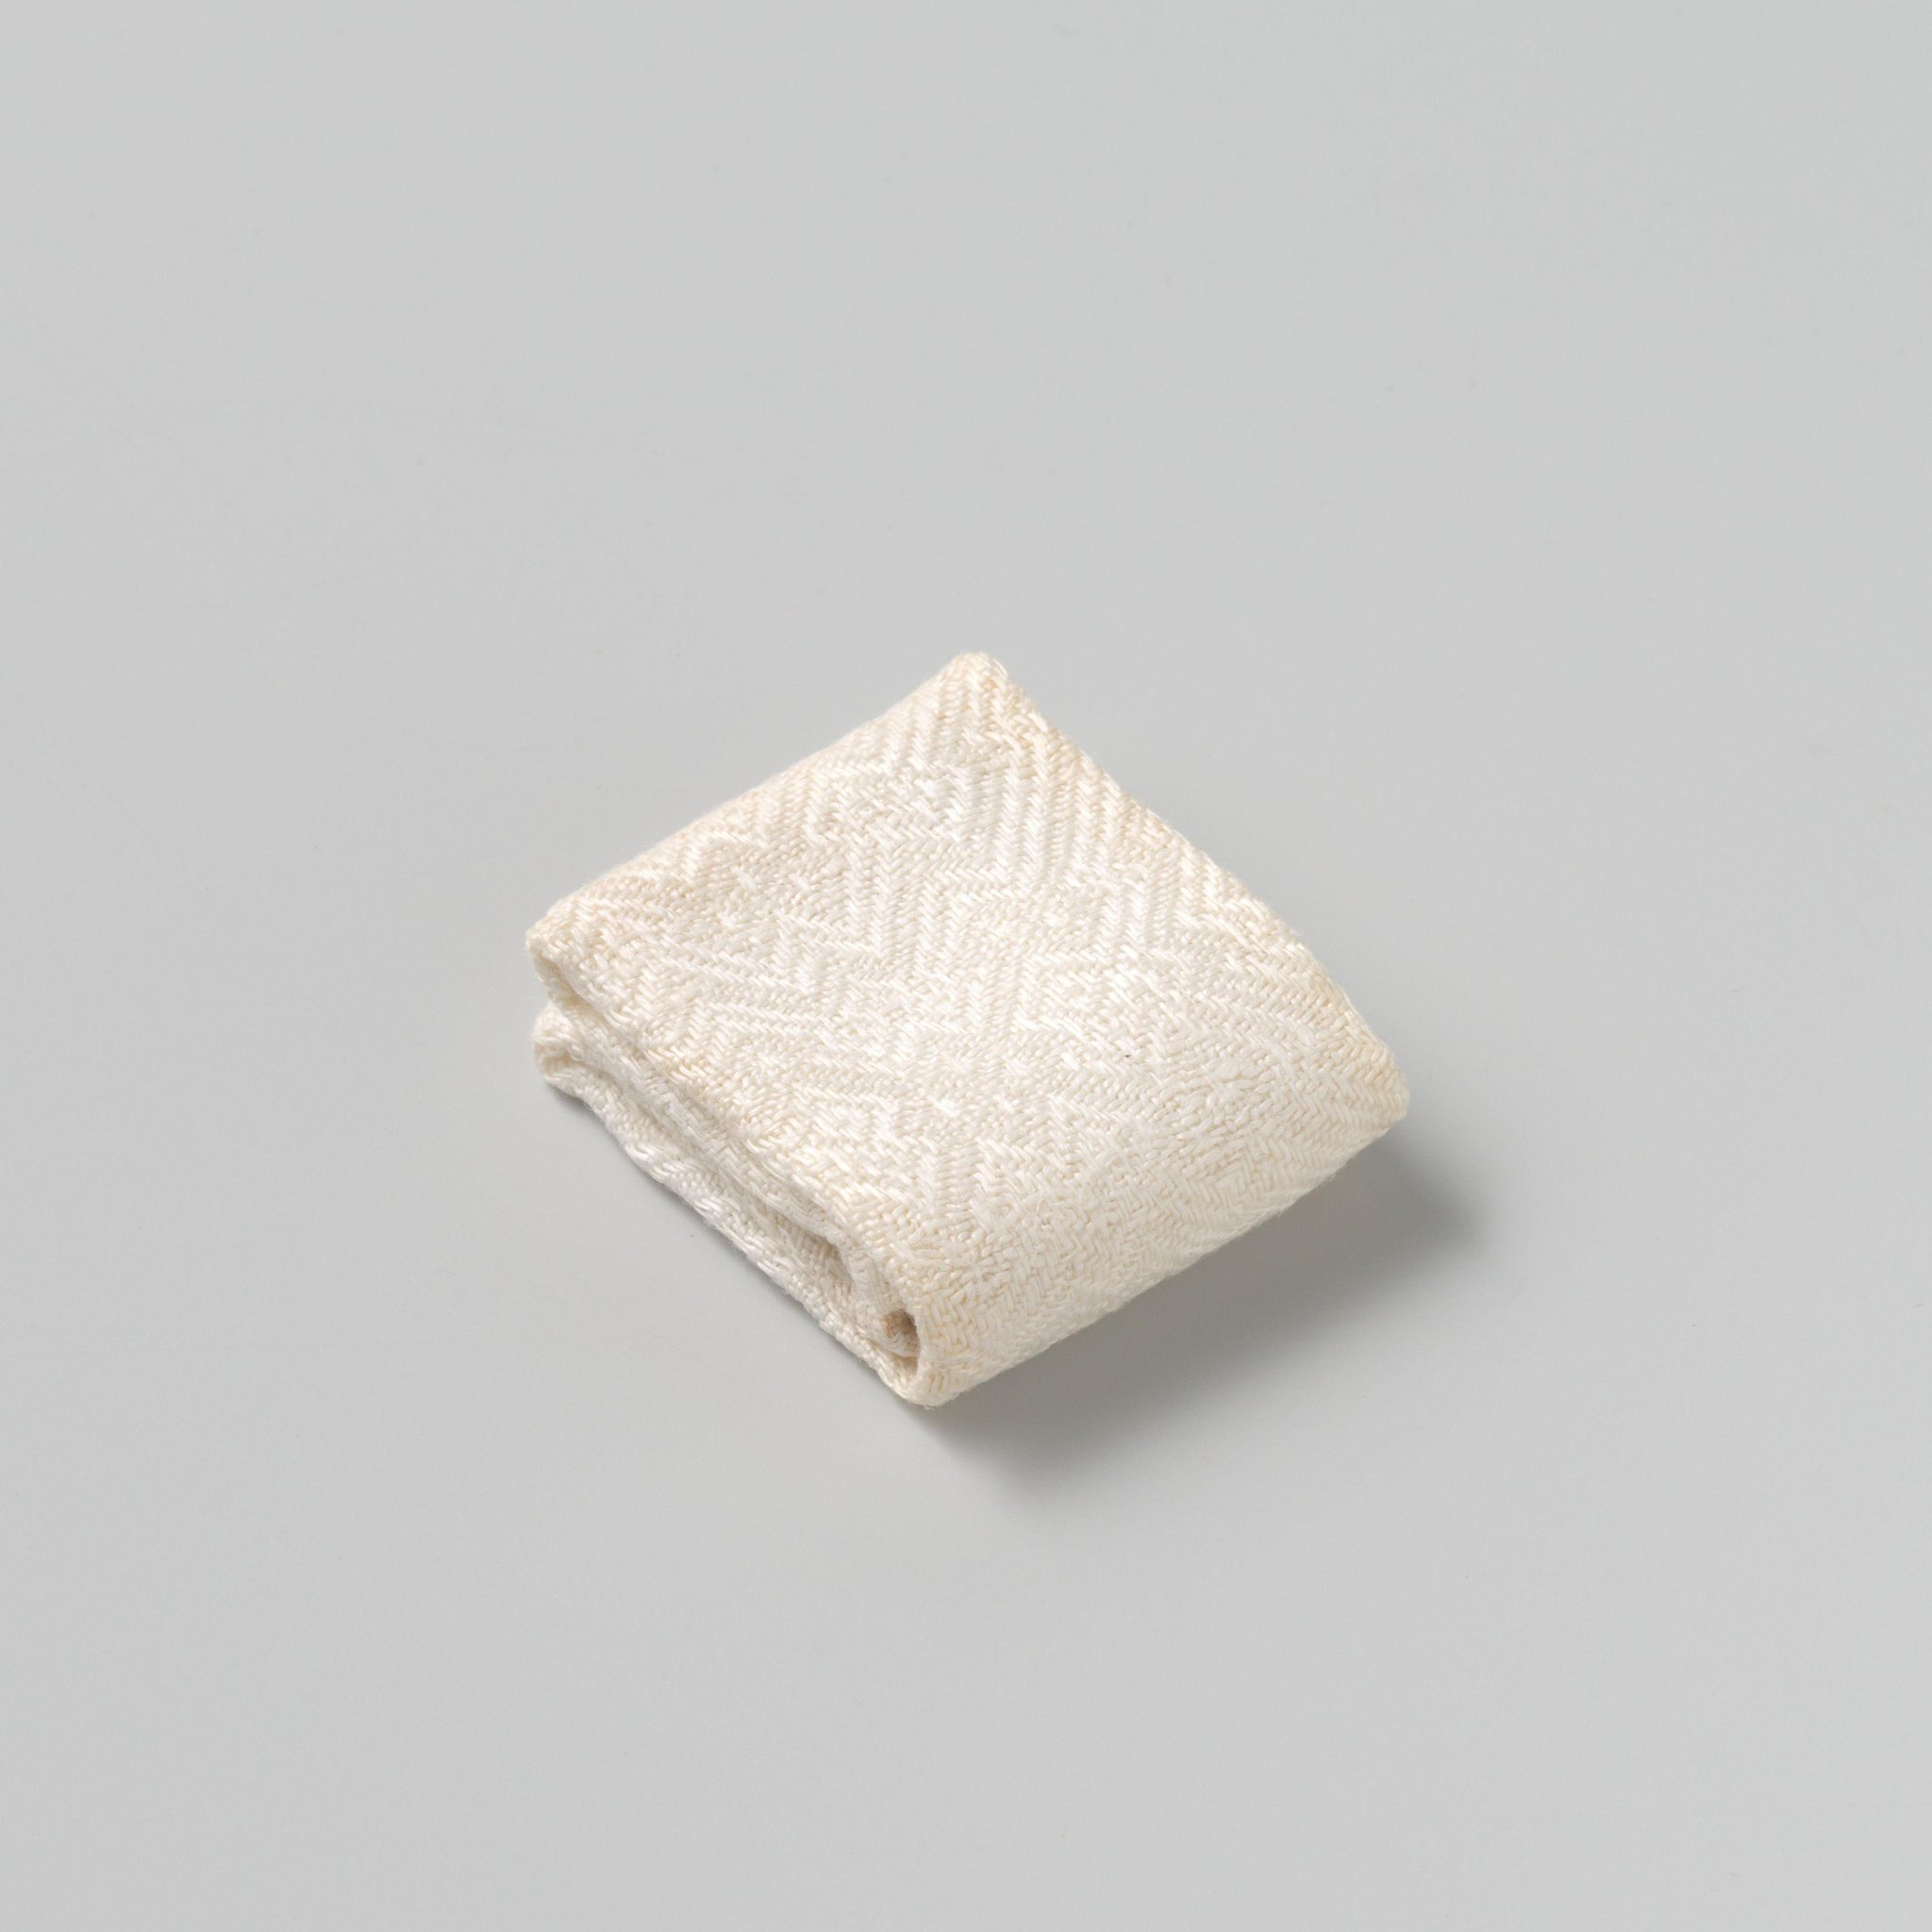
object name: miniature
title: Servet, damastweefsel met pellenpatroon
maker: Anonymous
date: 1600-1699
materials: linen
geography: netherlands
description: Servet, damastweefsel met een pellenpatroon, geknipt uit grotere stukken linnen en aan alle kanten omgezoomd met een fijne zoom.